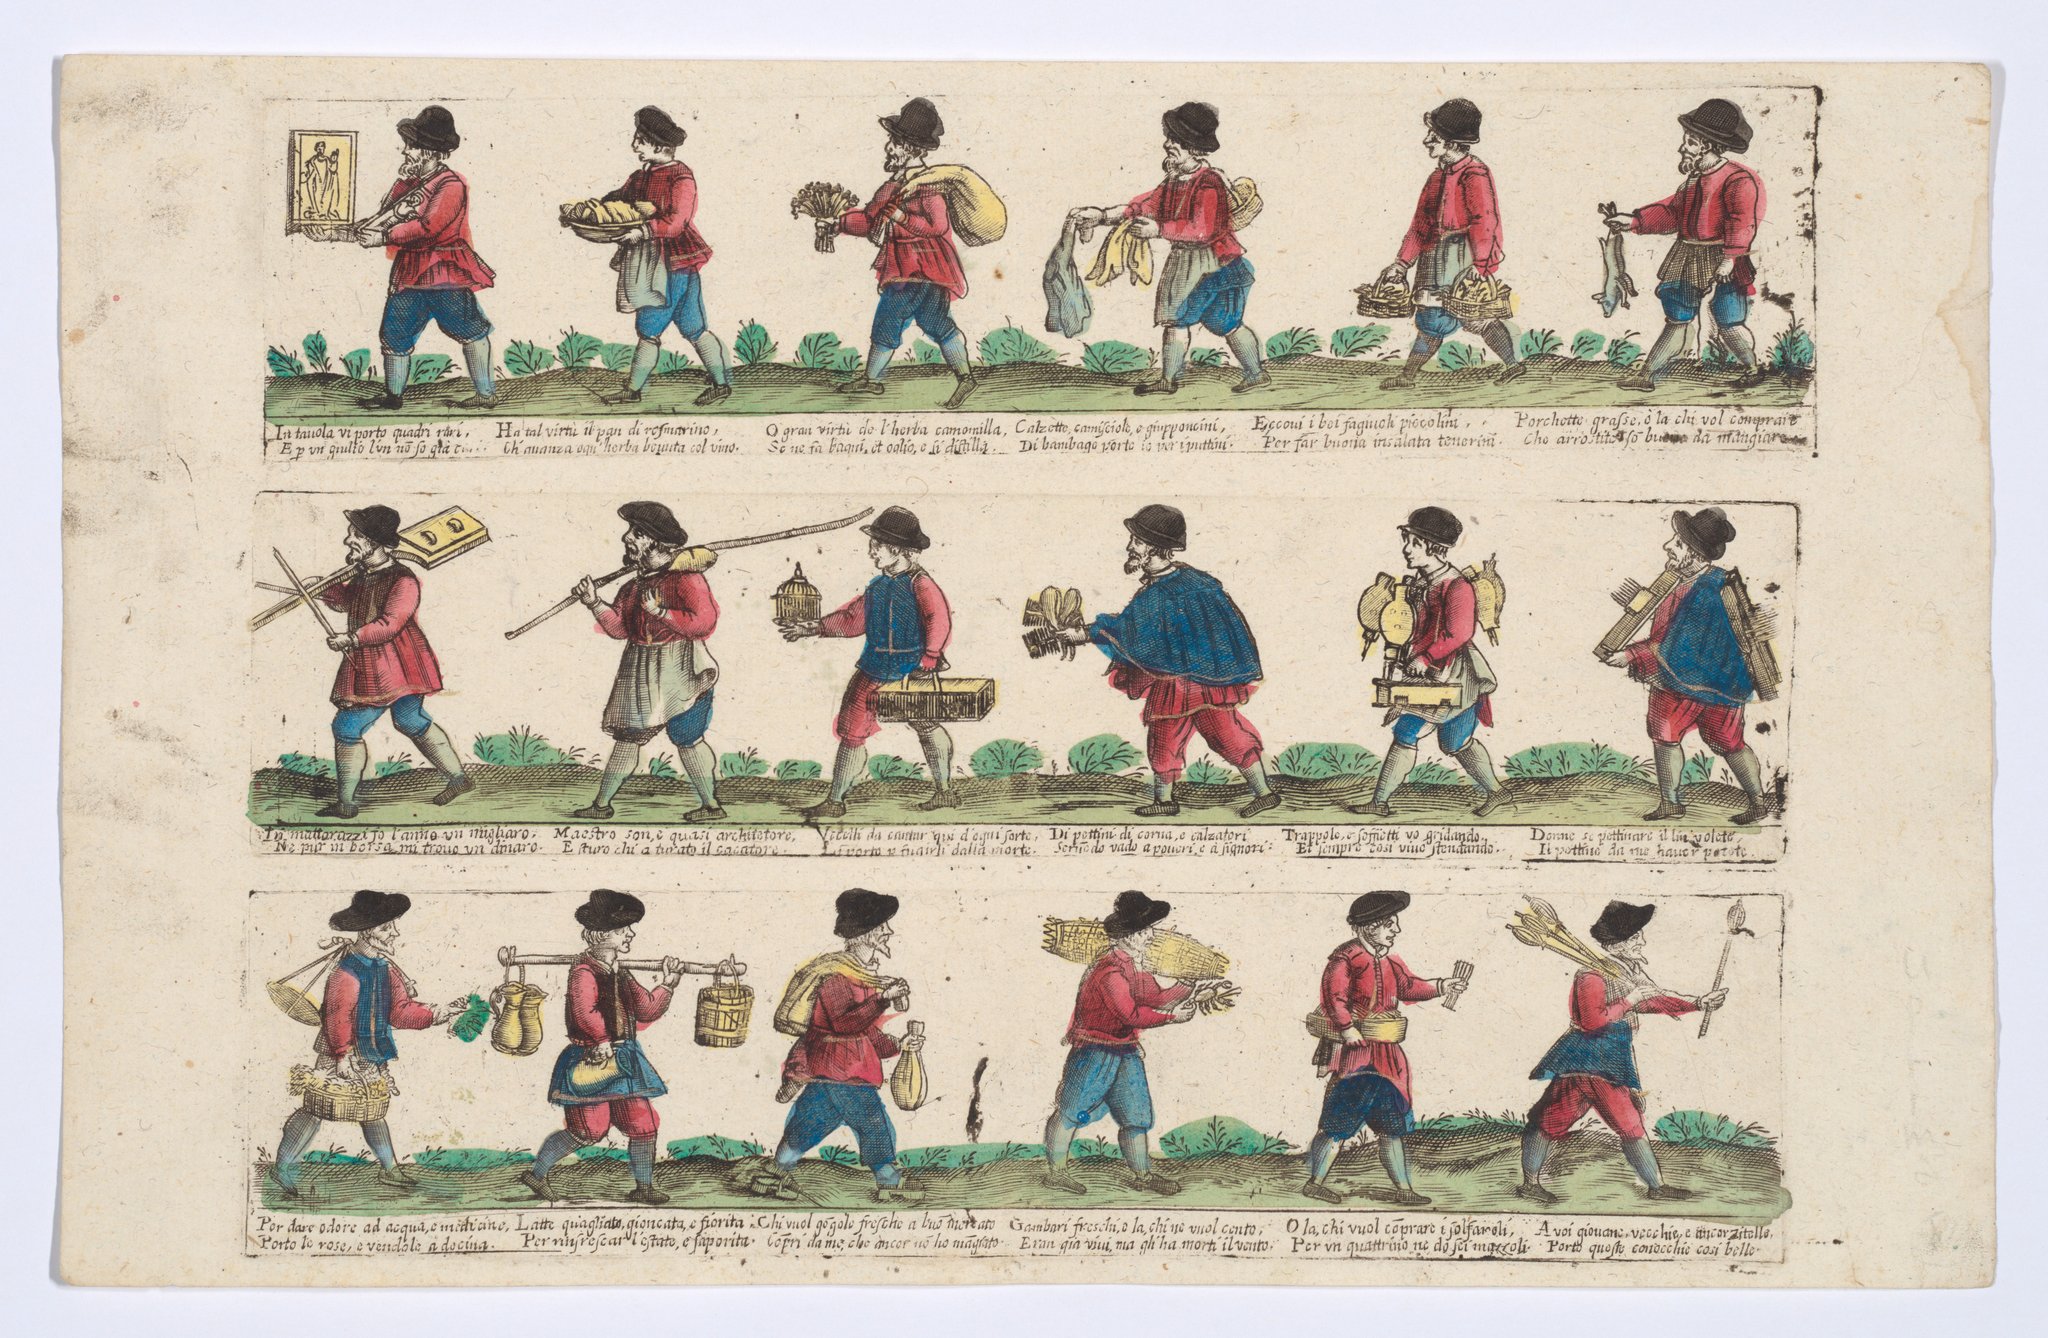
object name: print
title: Unnumbered plate depicting the trades of Rome, here including vendors of religious images, herbs, pigs, socks, bellows, milk, etc, from the 'Descrición de las artes que se llaman para los calles de la ciudad de Roma'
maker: remondini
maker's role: publisher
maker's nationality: italian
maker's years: 1650-1860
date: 1770-1800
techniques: engraving, hand coloring